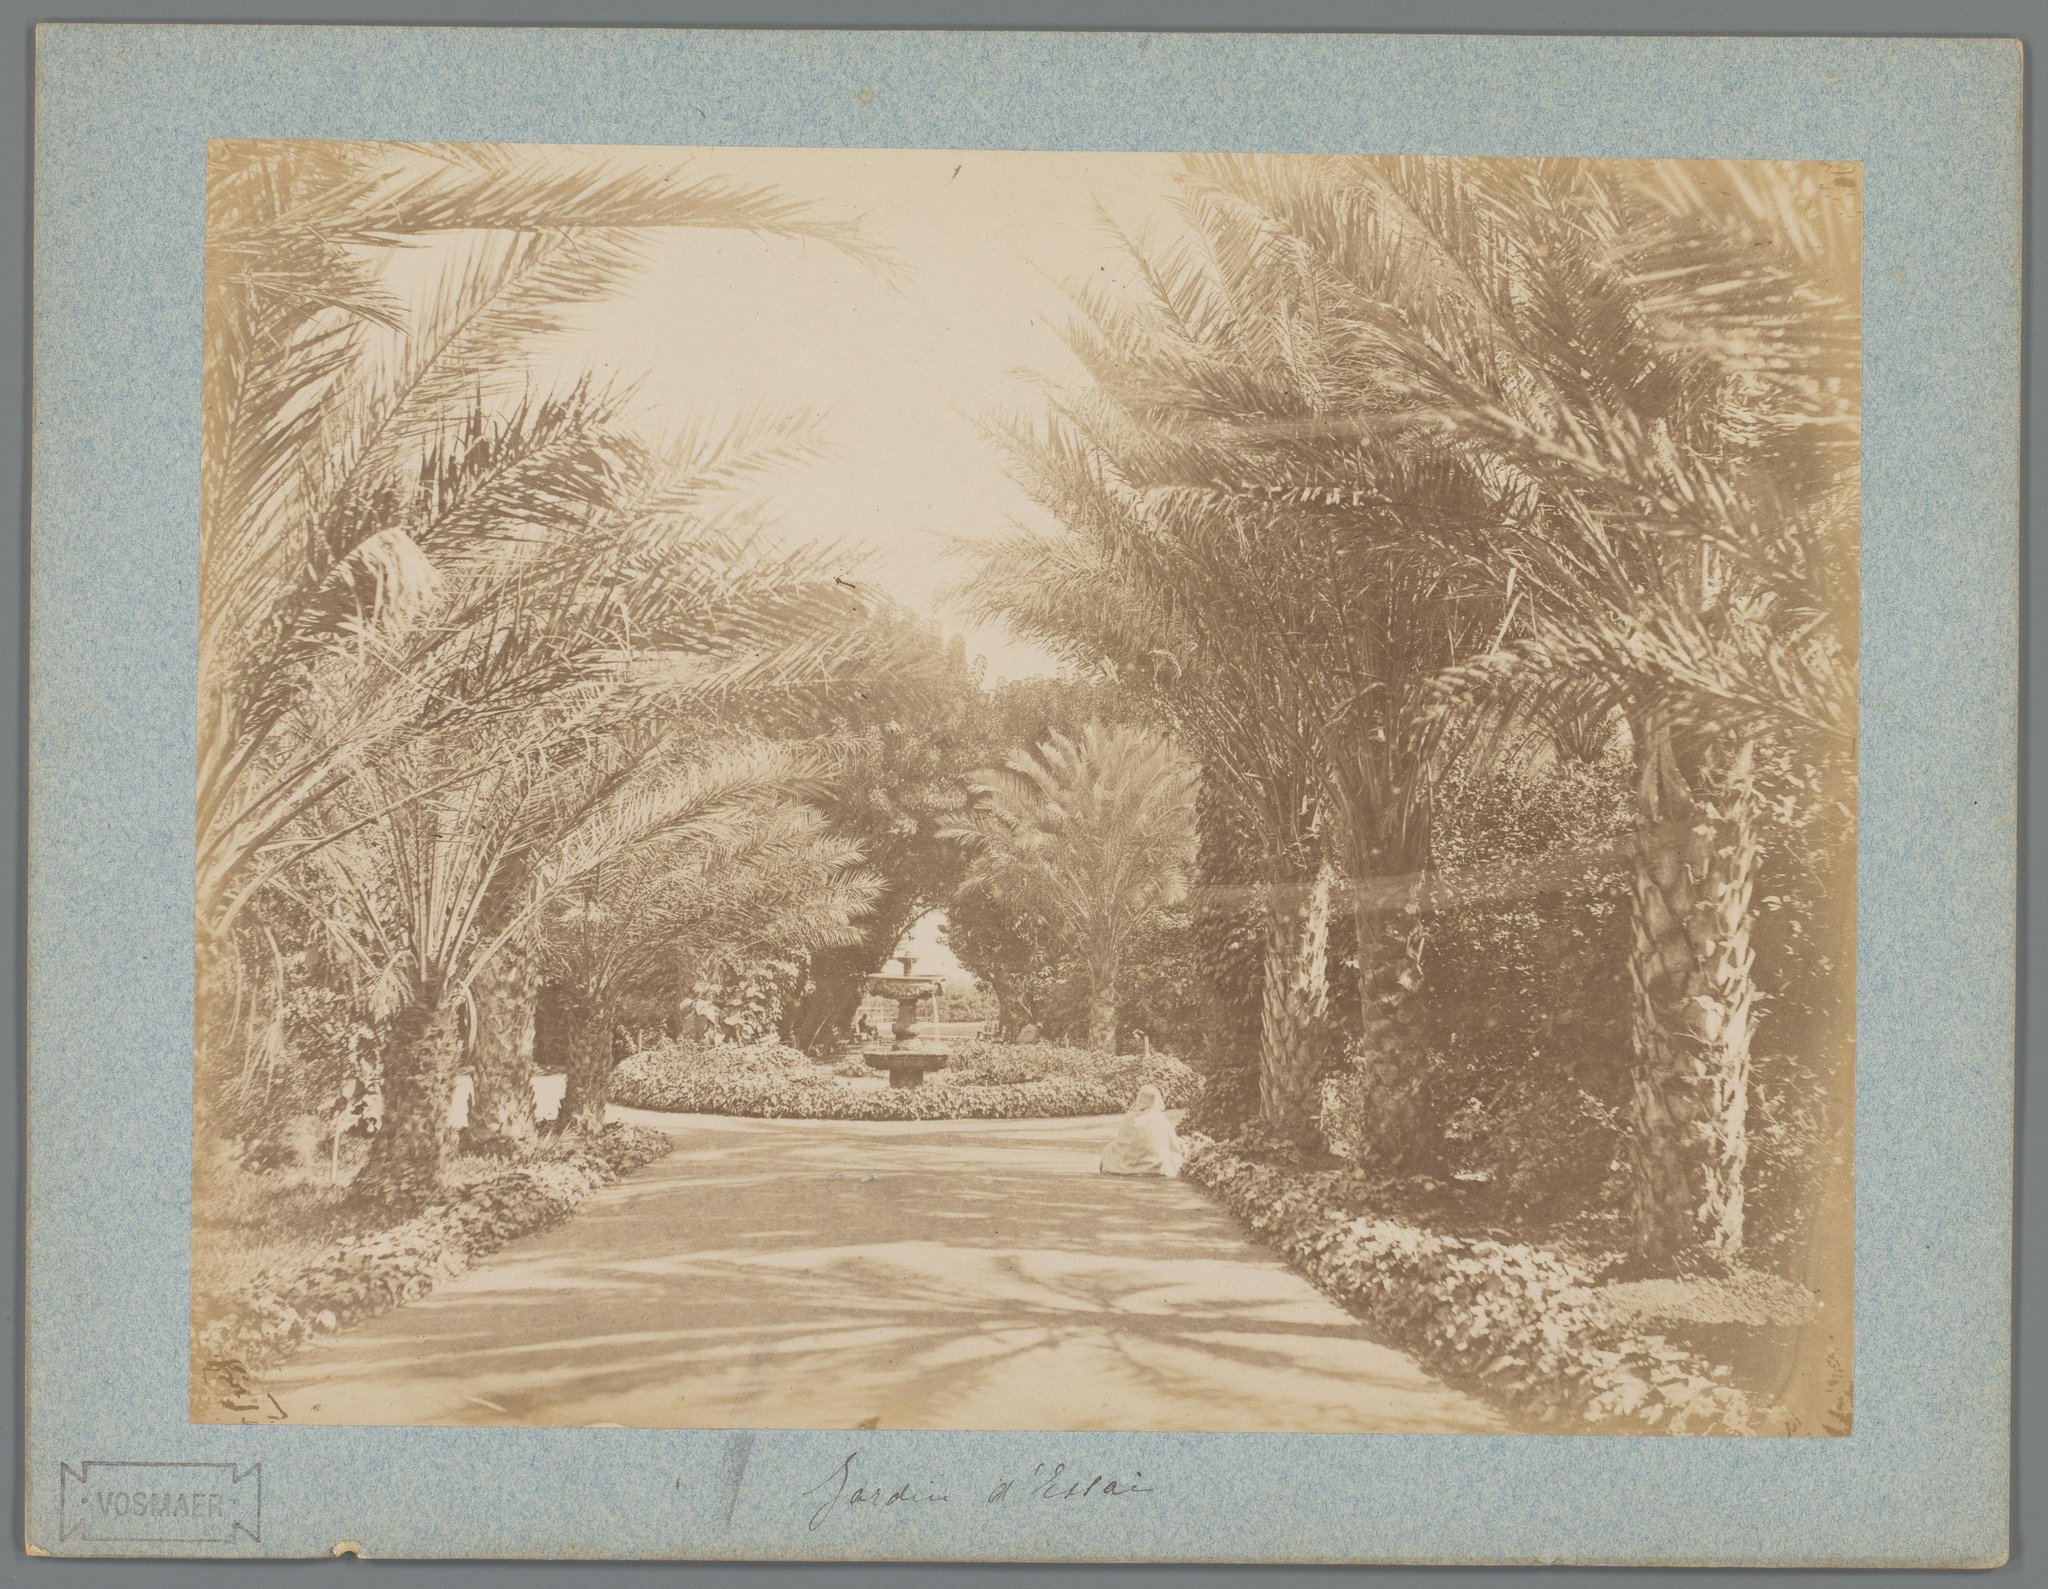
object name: photograph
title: Botanische tuin van Hamma in Algiers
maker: Anonymous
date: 1851-1900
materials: cardboard, paper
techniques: albumen print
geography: algiers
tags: botanic garden, 'hortus botanicus', botanical garden hamma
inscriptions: collector's mark: ‘VOSMAER’, inscription: ‘Jardin d'Essai’